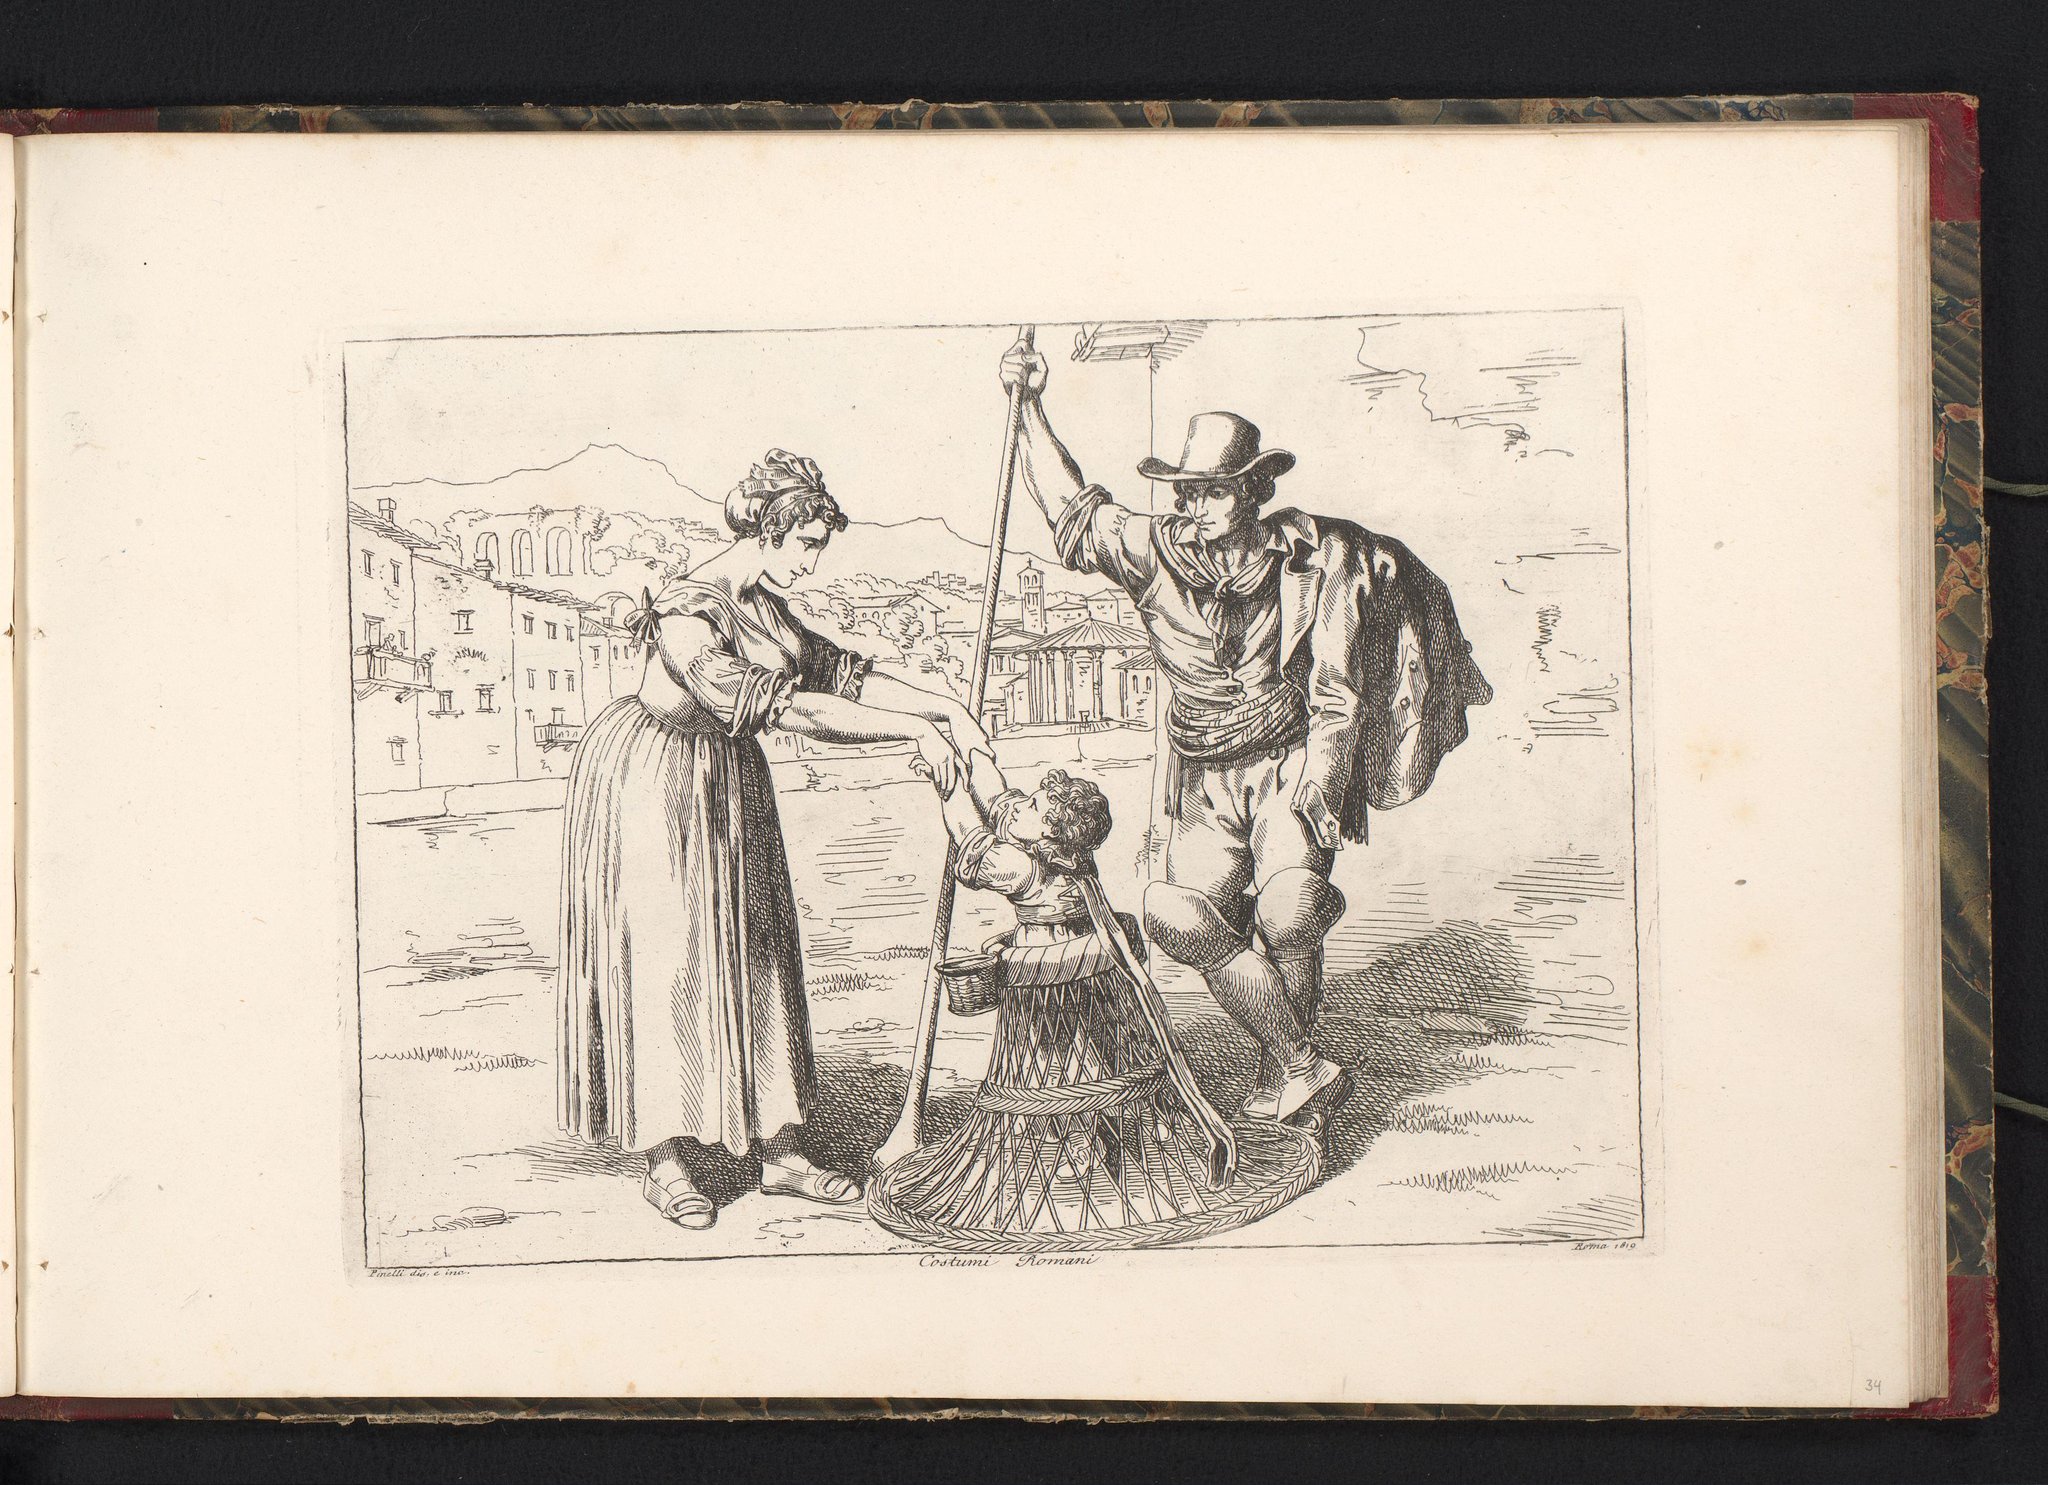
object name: print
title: Costumi Romani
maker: bartolomeo pinelli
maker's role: draughtsman, print maker, sculptor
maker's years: 1781-1835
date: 1819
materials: paper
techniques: etching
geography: rome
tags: city-view in general; 'veduta', folk costume, regional costume, implements for learning to walk, go-cart, learning to walk, the first steps, rome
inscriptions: date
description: Een Romeins gezin met een kind dat leert lopen met een rieten looprek. Op de achtergrond een gezicht op een stad, mogelijk met het Forum Boarium en de Santa Maria in Cosmedin te Rome. De prent maakt deel uit van een album.